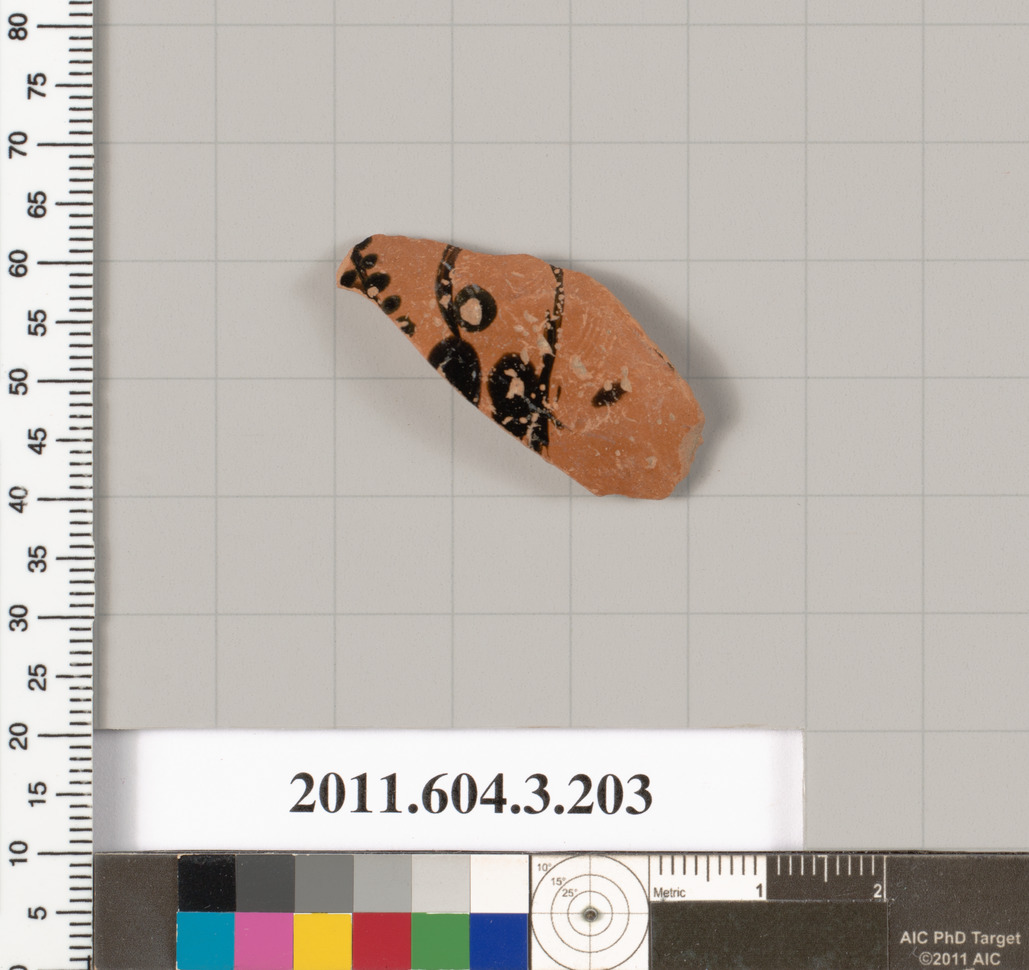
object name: neck amphora fragment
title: Terracotta fragment of a neck-amphora (jar)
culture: greek, attic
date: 530-520 BCE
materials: terracotta